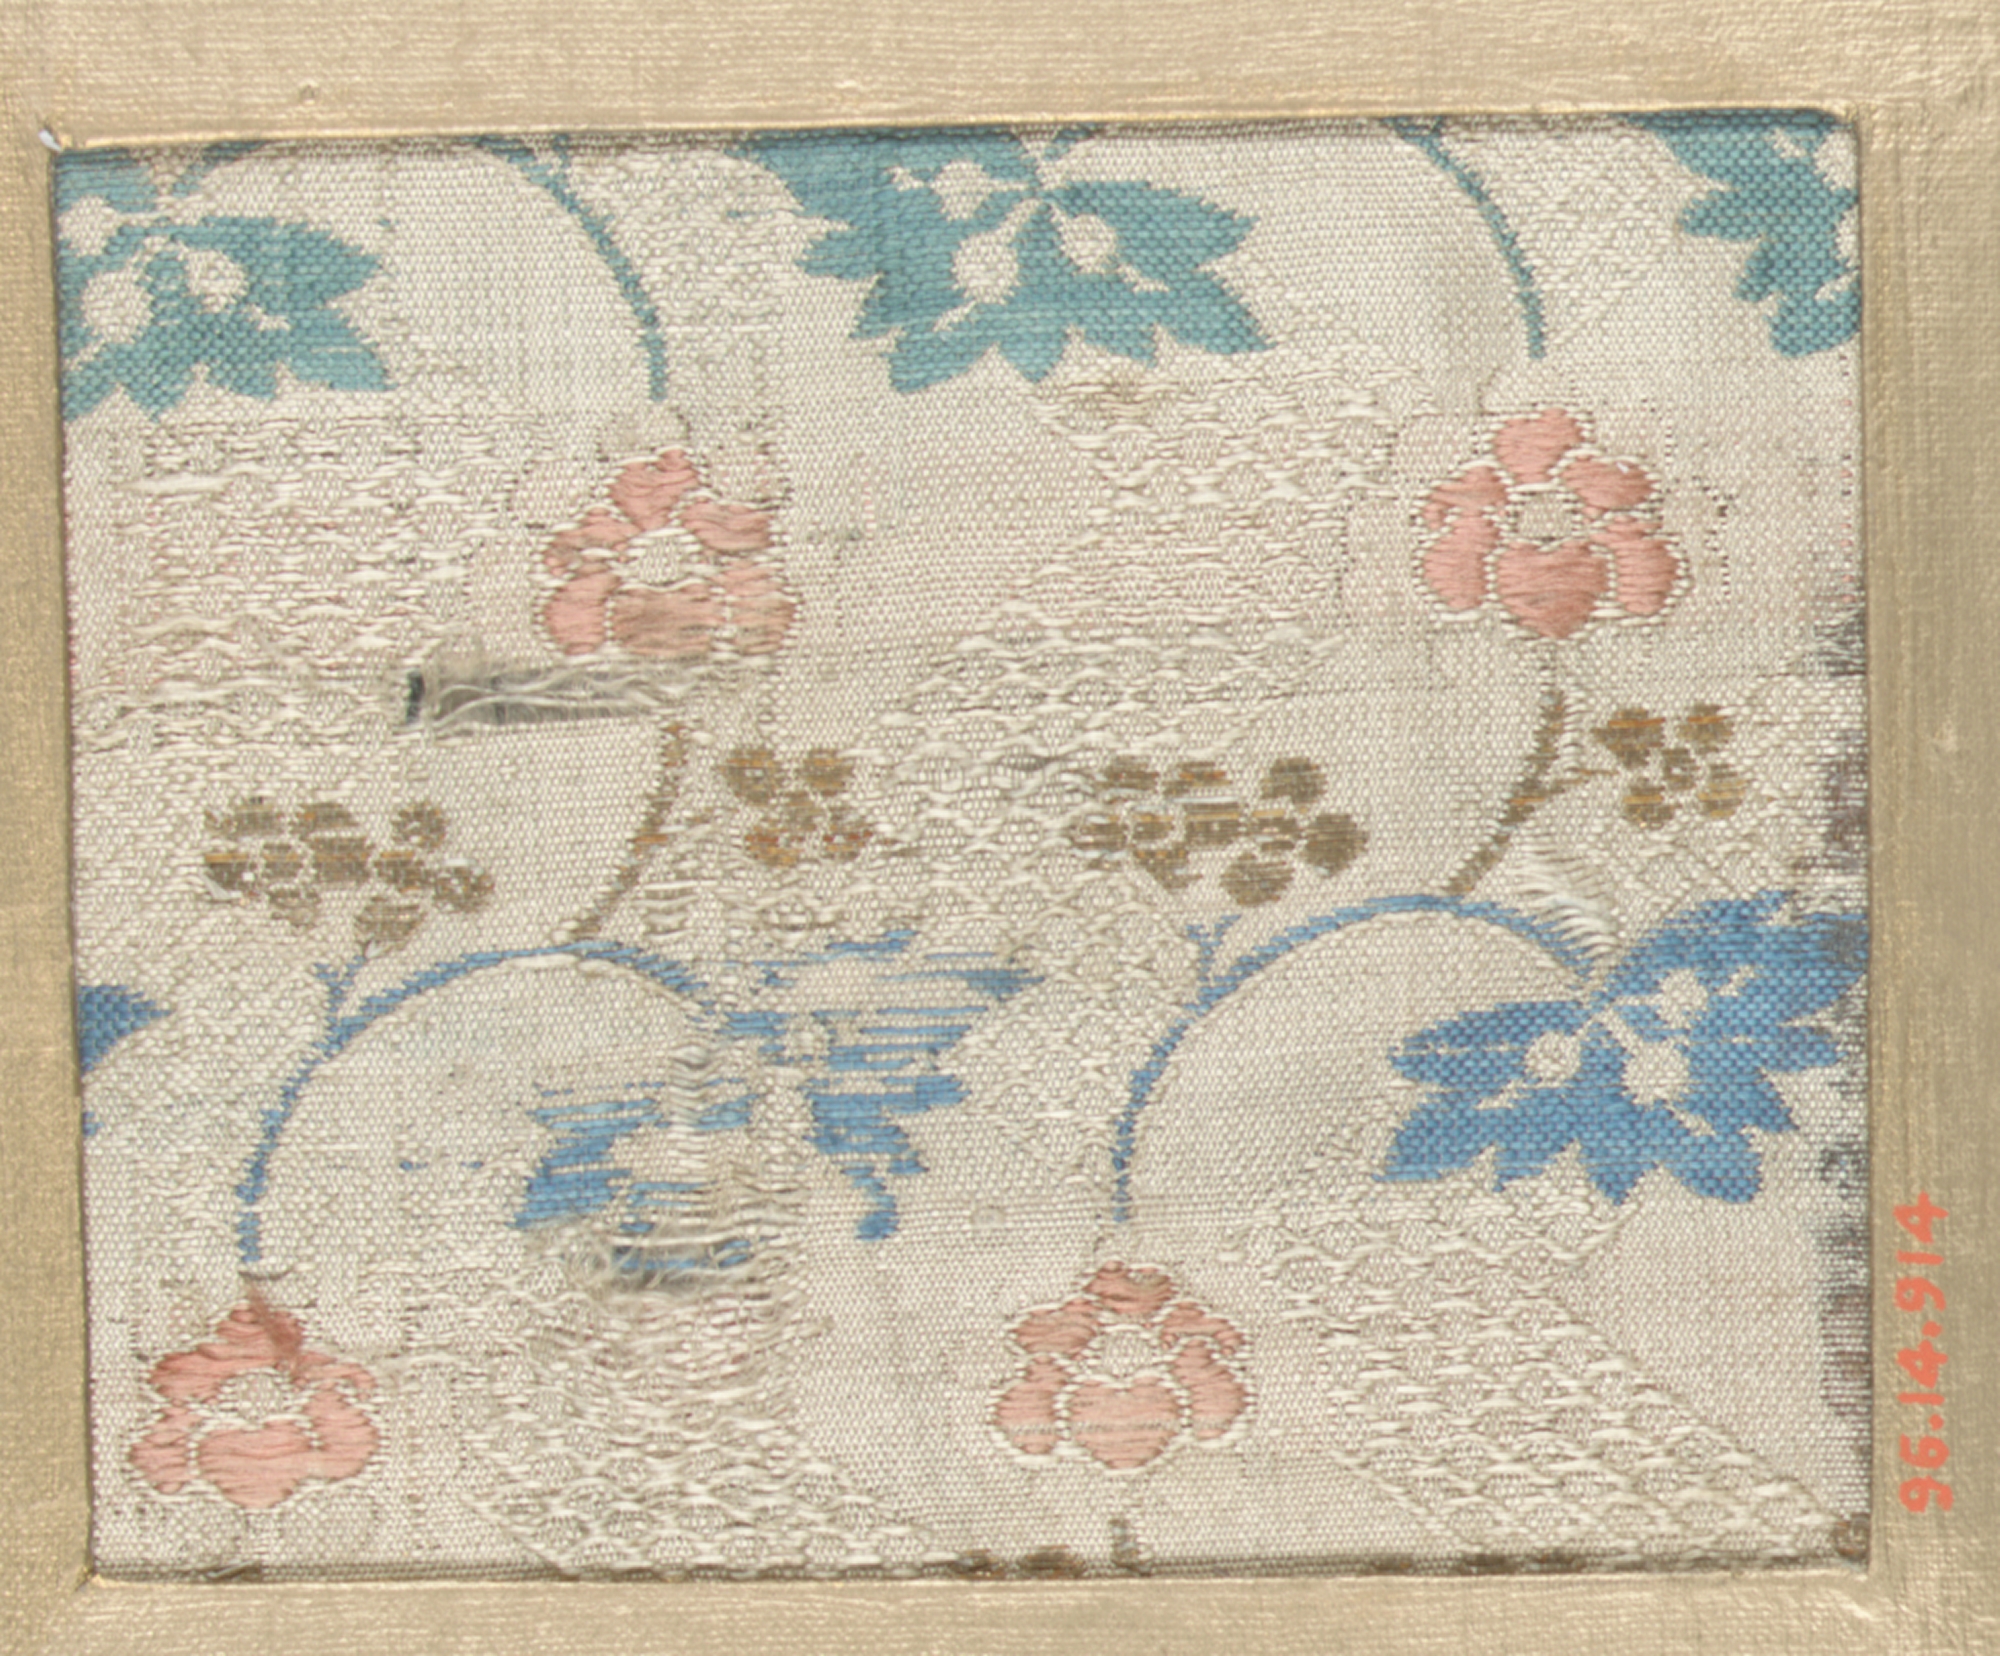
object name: piece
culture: japanese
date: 1701-1900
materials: silk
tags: leaves